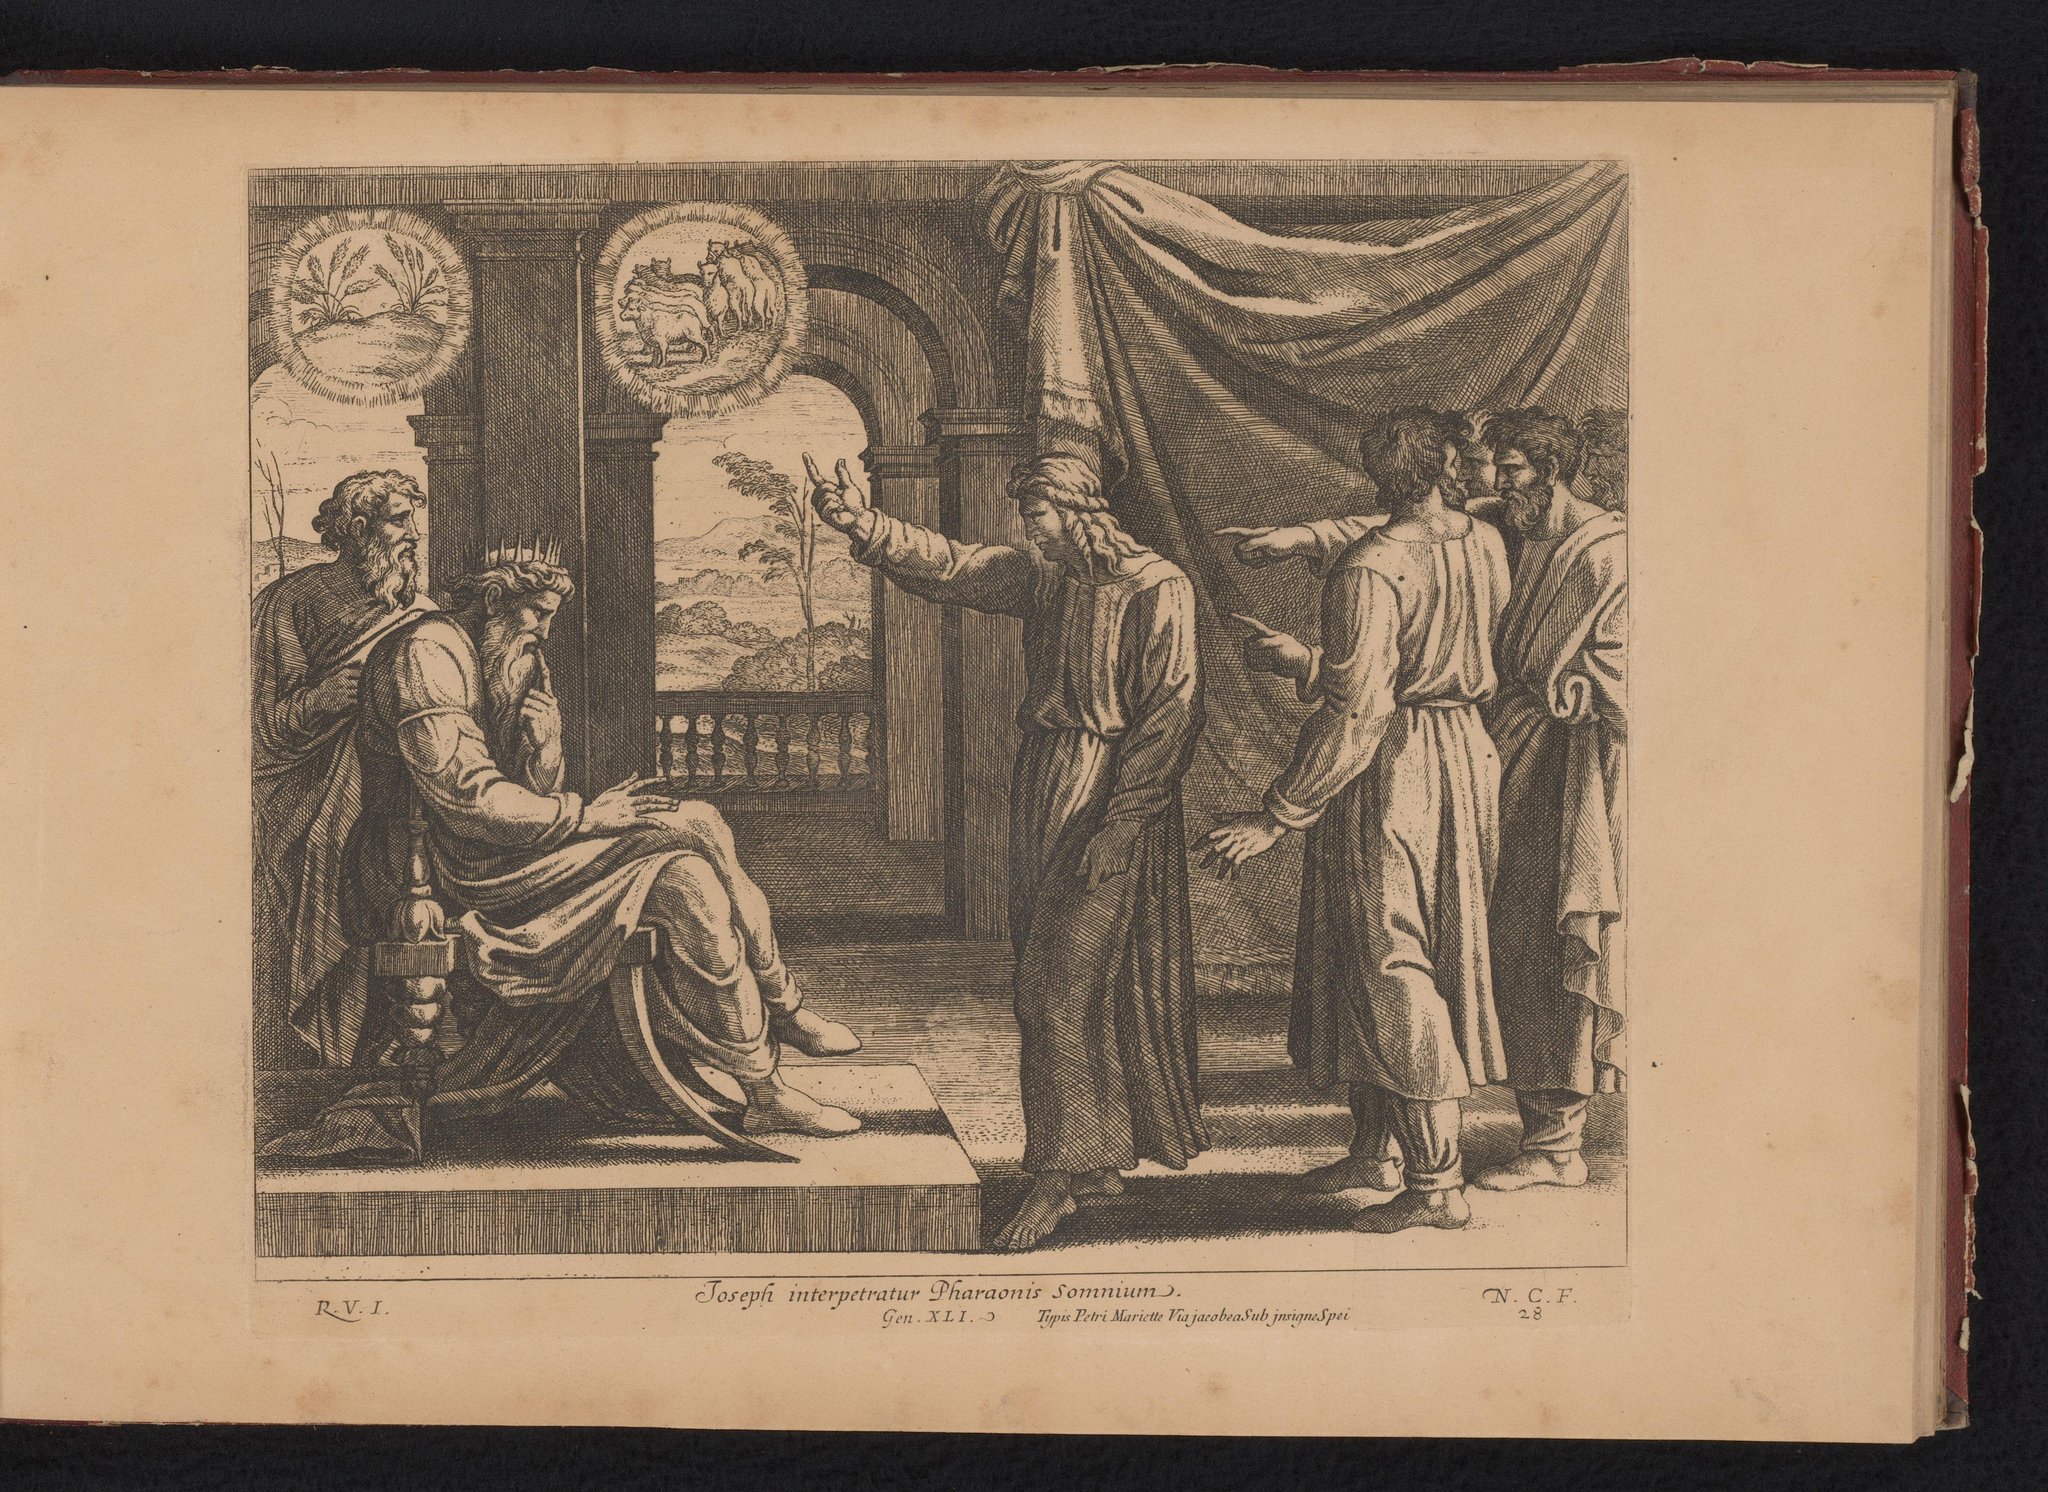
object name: print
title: Jozef legt de dromen van de farao uit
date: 1649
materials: paper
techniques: etching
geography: paris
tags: first dream of pharaoh: seven fat cows are devoured by seven lean cows ~ story of joseph, joseph interpreting pharaoh's dreams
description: Deze prent maakt deel uit van een album.